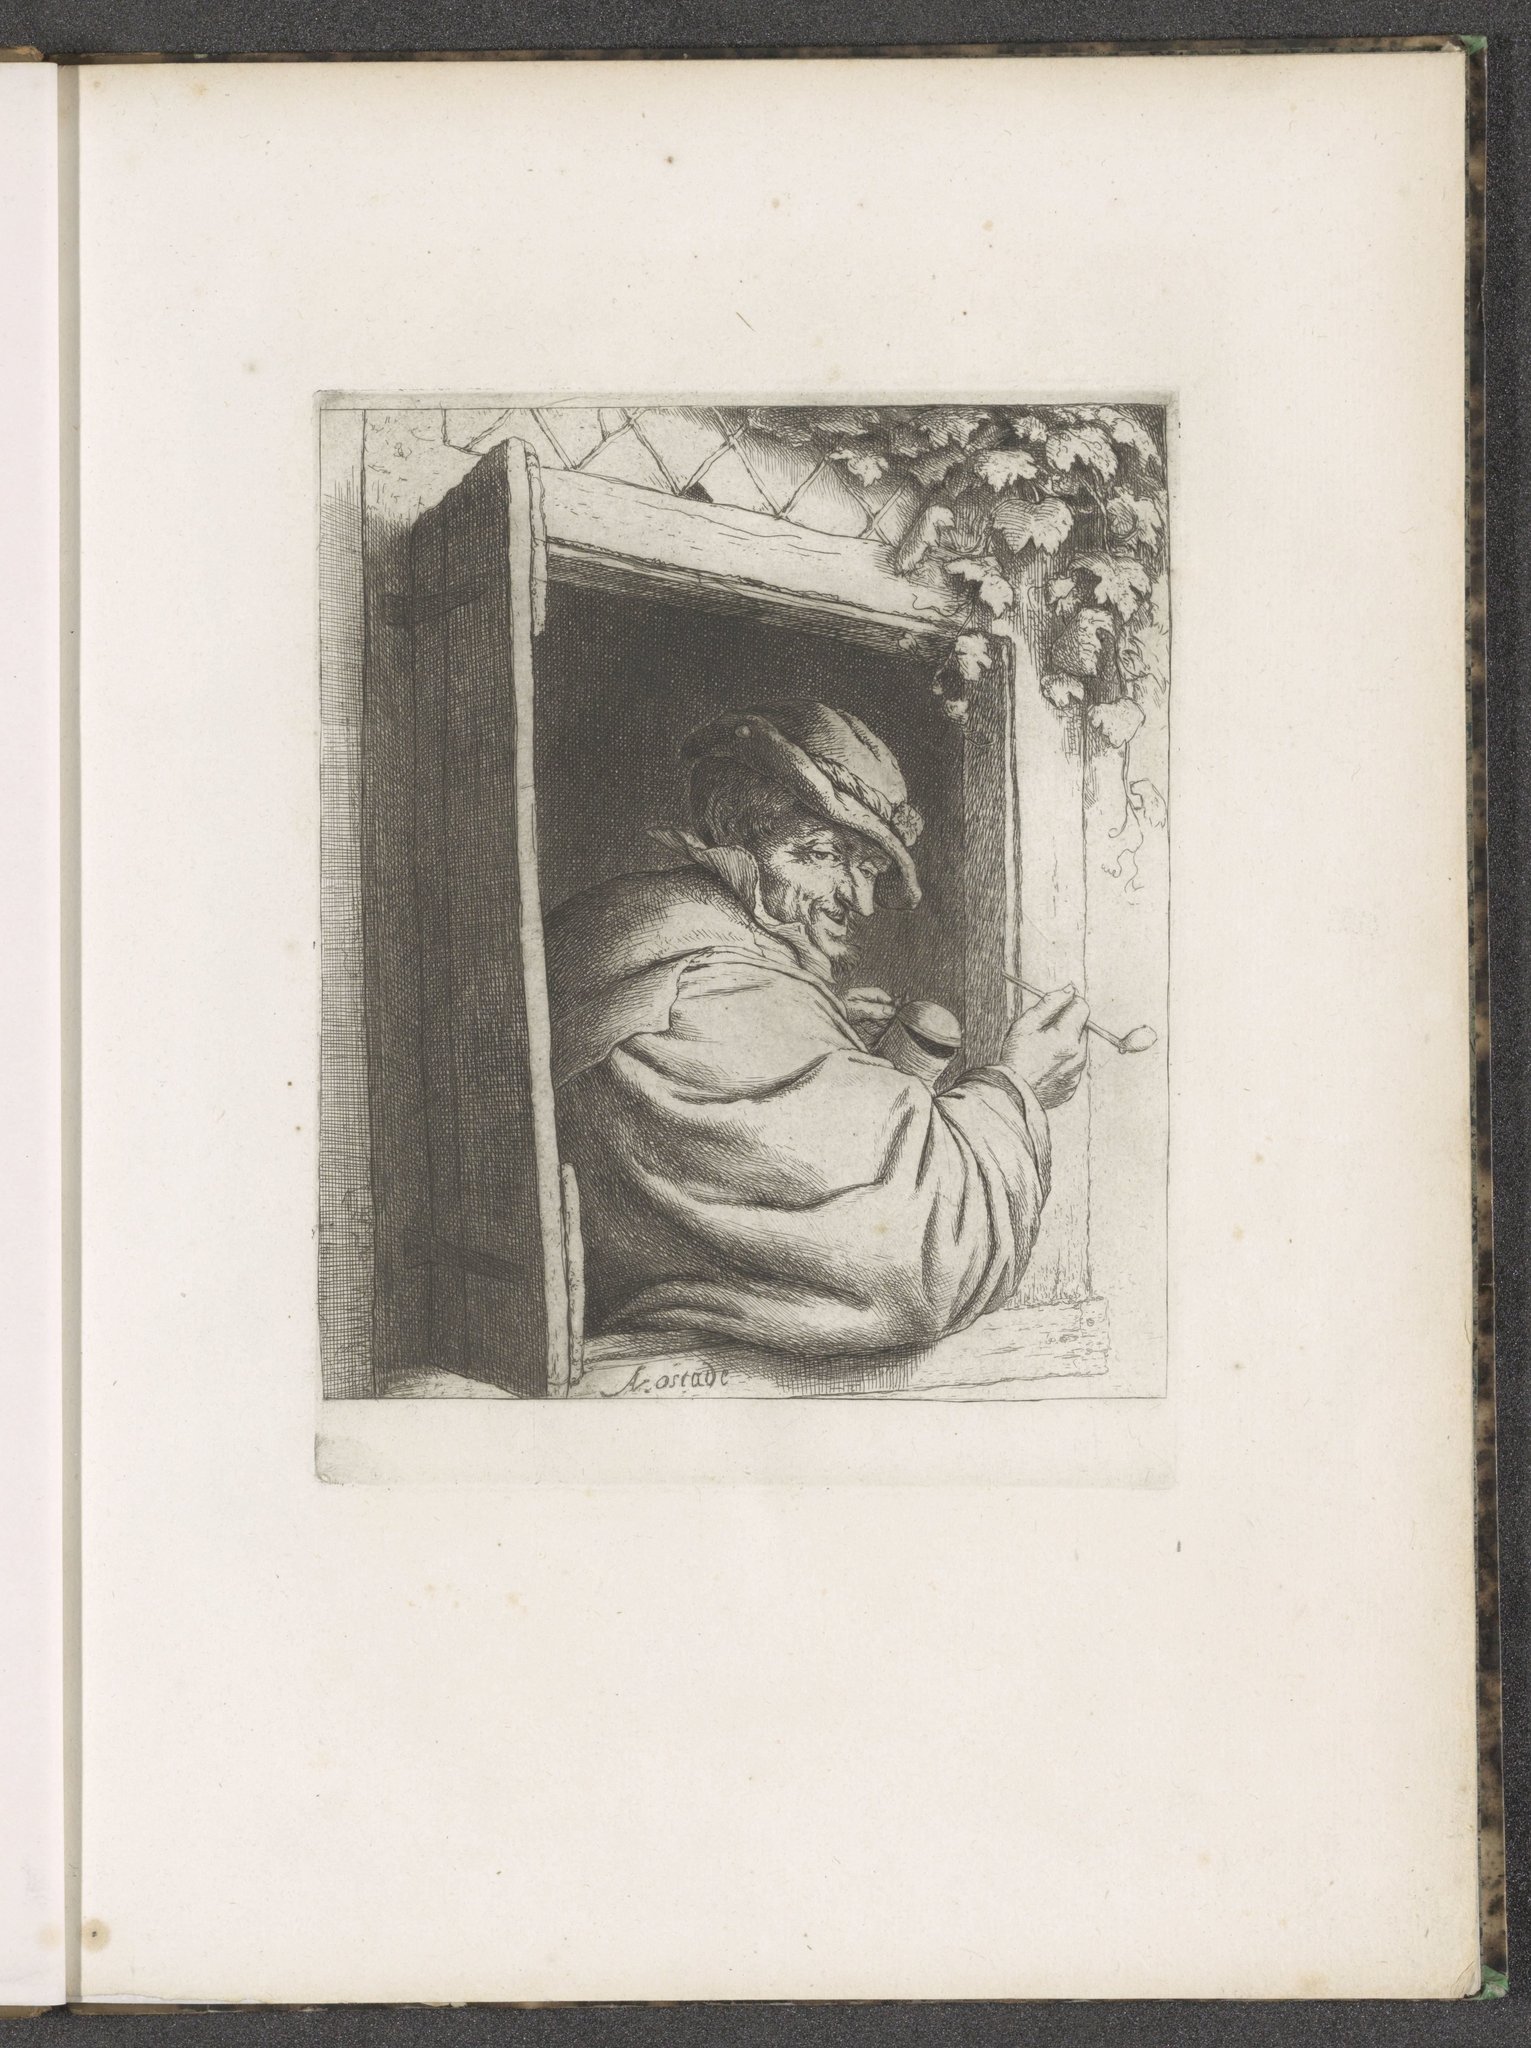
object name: print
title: Rokende man in een raamopening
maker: adriaen van ostade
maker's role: draughtsman, painter, print maker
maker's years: 1610-1685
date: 1648-1650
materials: paper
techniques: etching, intaglio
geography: haarlem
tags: adult man, pipe ~ tobacco, open window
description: Man met een pijp en een drinkbeker in een raamopening met een naar buiten openslaand luik. Deze prent maakt deel uit van een album.